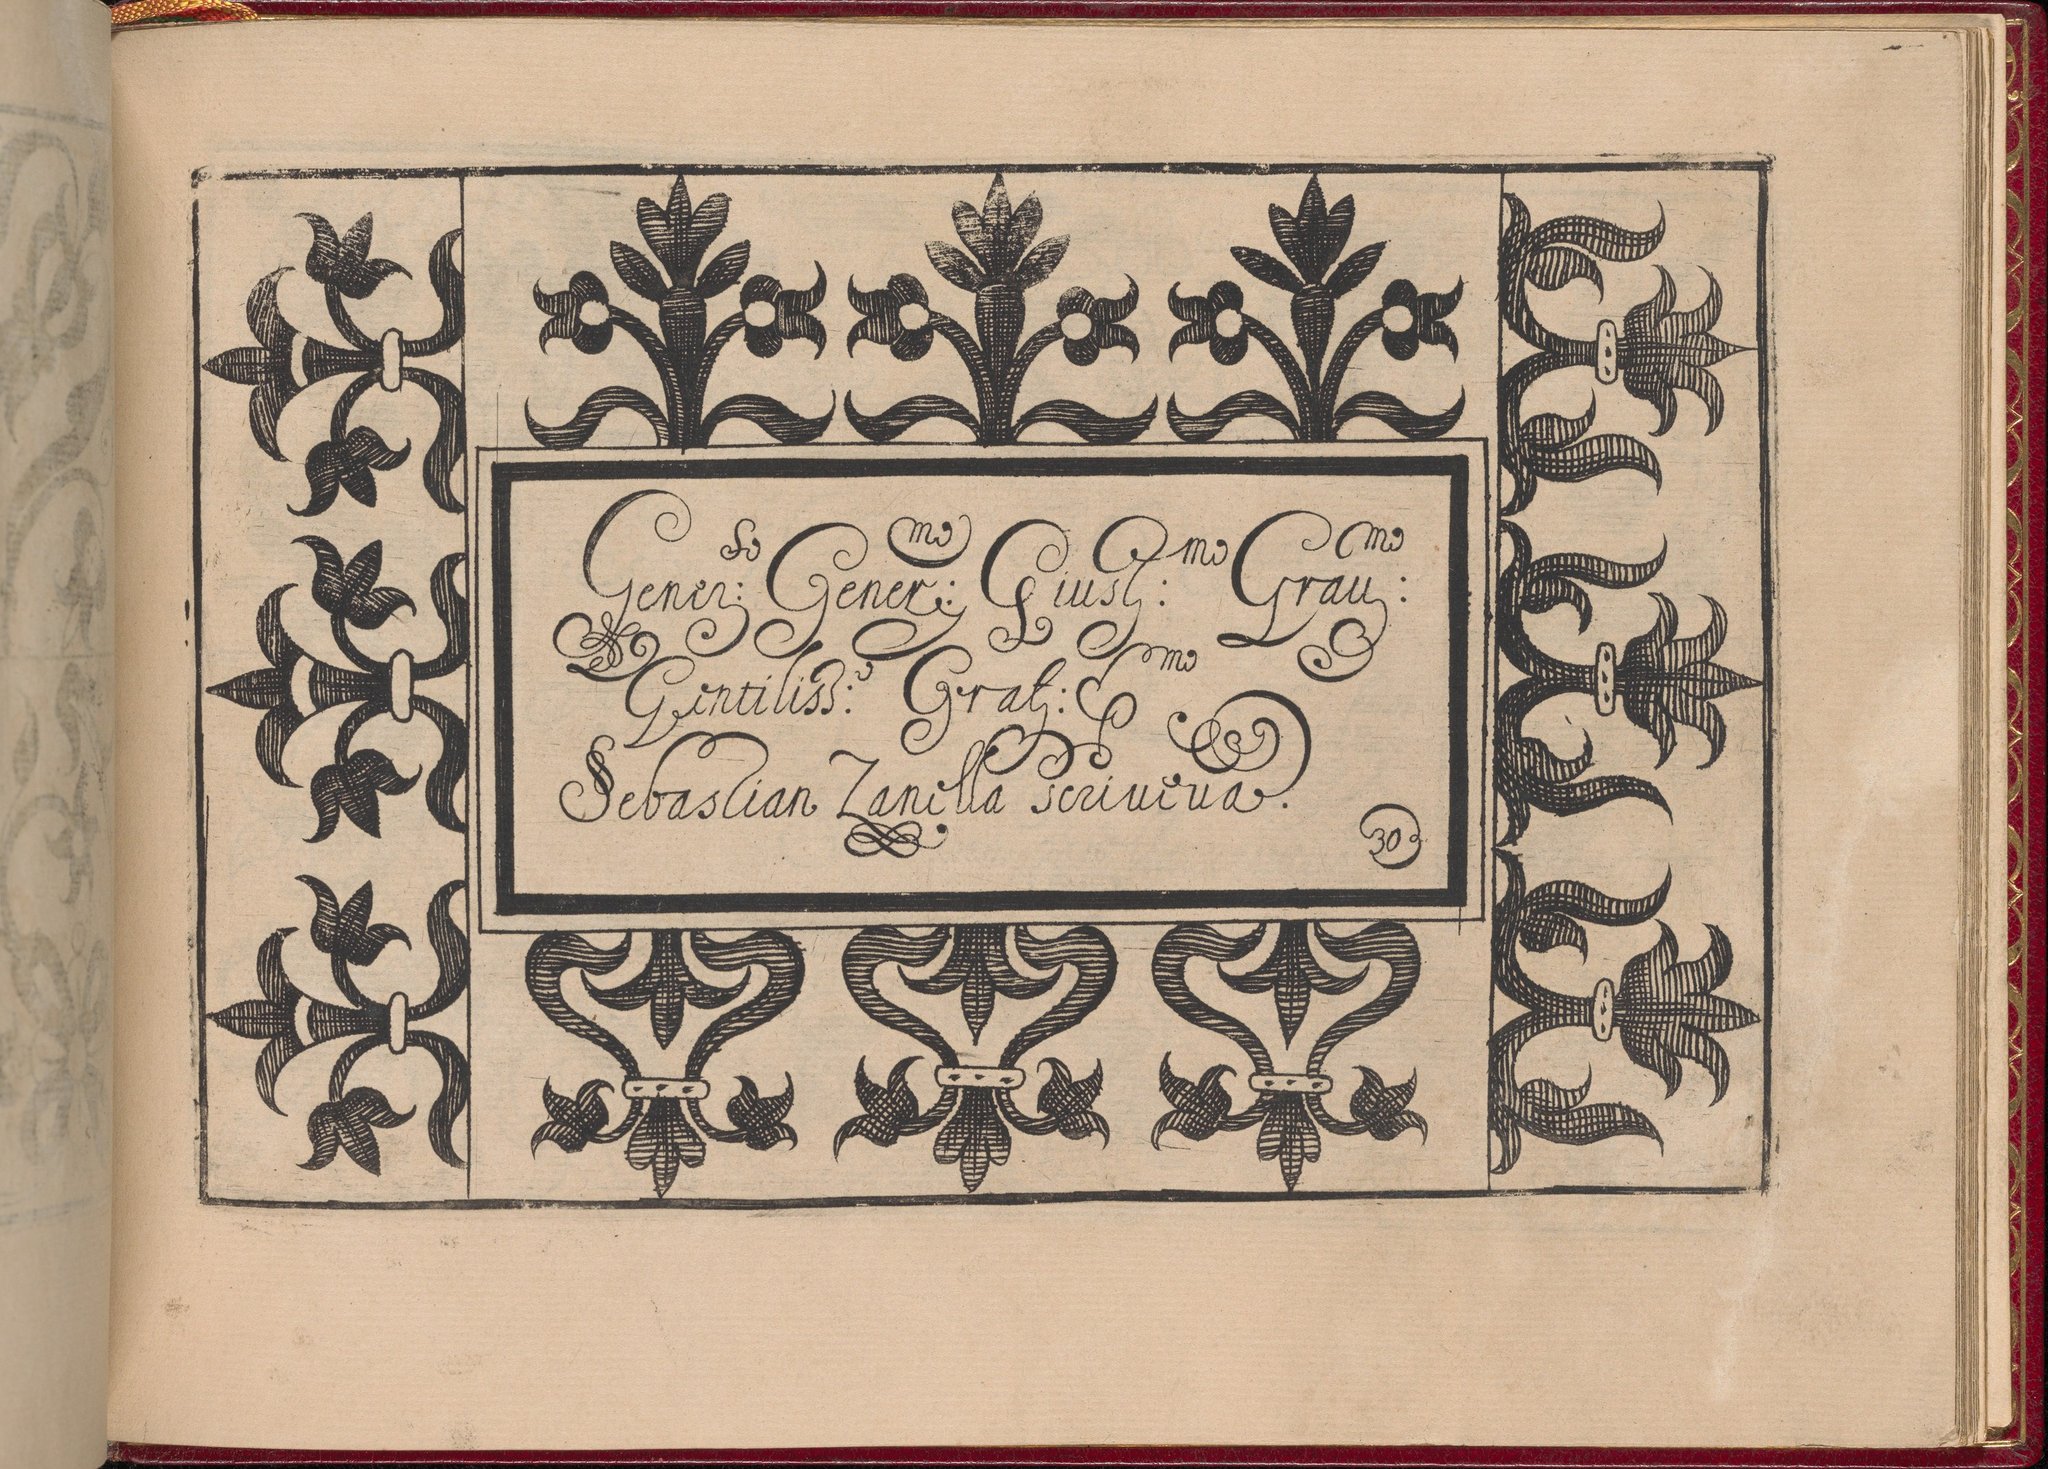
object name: book print ornament architecture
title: Ghirlanda: Di sei vaghi fiori scielti da piu famosi Giardini d'Italia, page 38 (recto)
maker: pietro paulo tozzi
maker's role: designer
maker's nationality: italian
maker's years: 1593-1628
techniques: drawing, etching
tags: ornament